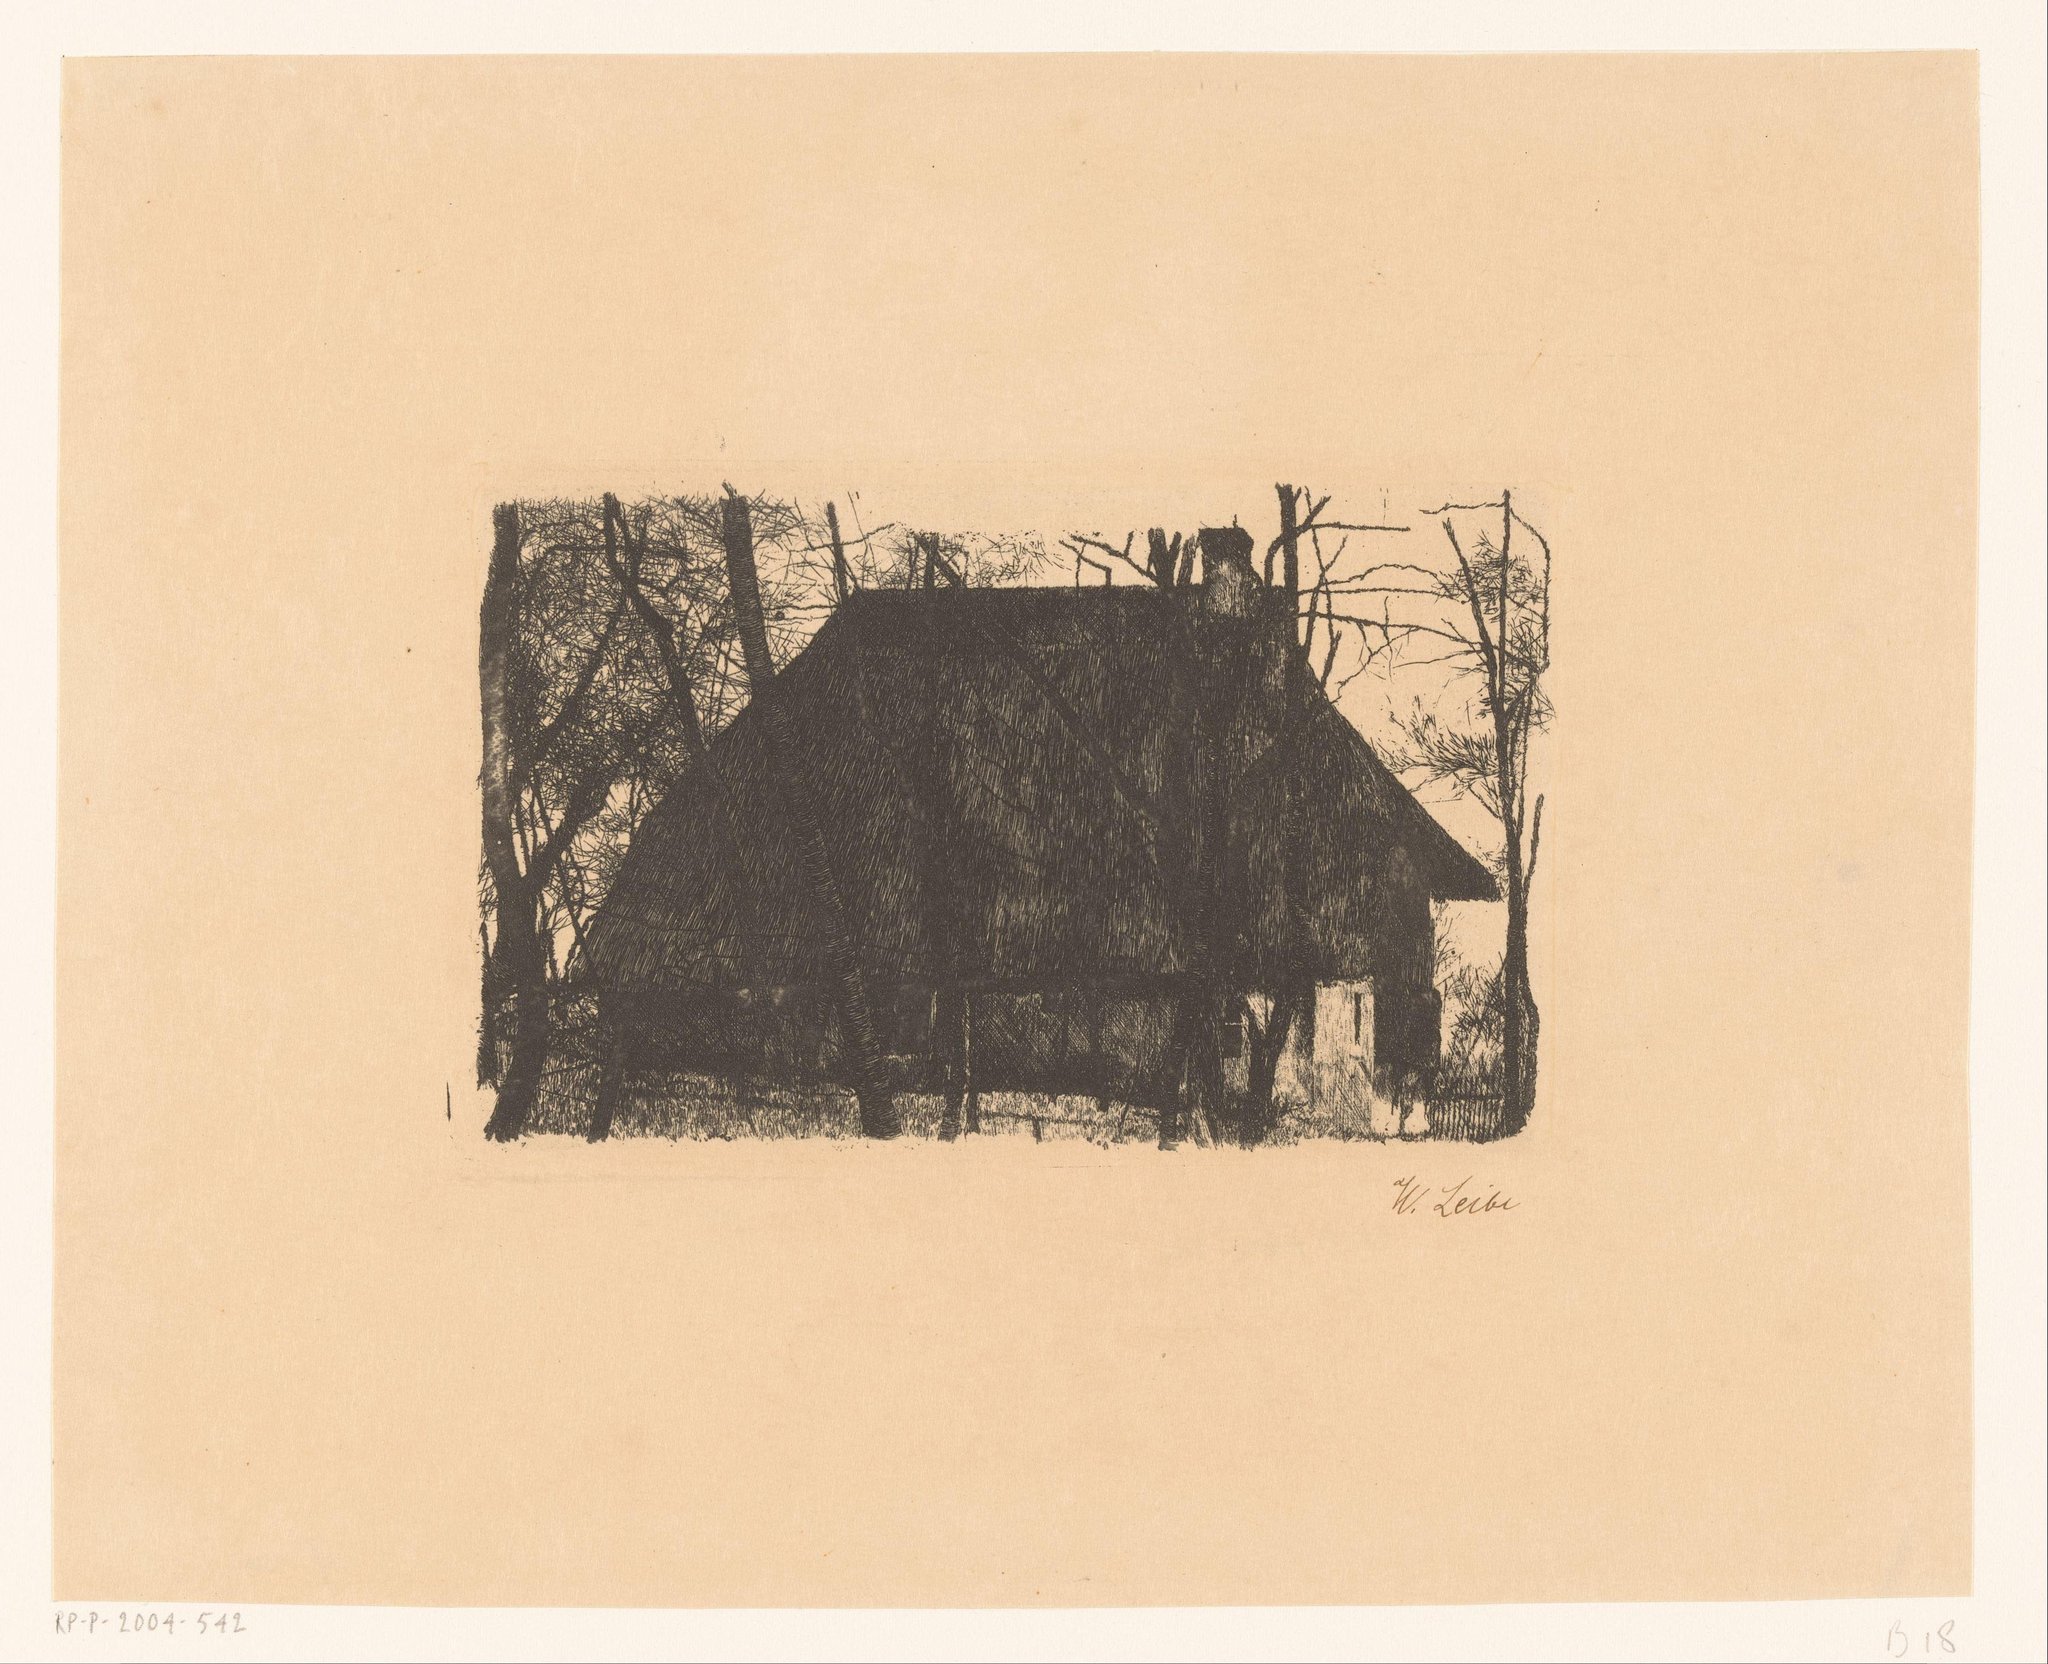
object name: print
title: Boerderij tussen kale bomen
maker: wilhelm maria hubertus leibl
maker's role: print maker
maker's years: 1844-1900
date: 1875-1877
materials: paper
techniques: etching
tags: farm or solitary house in landscape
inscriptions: collector's mark: Lugt 2760, collector's mark: Lugt 2228